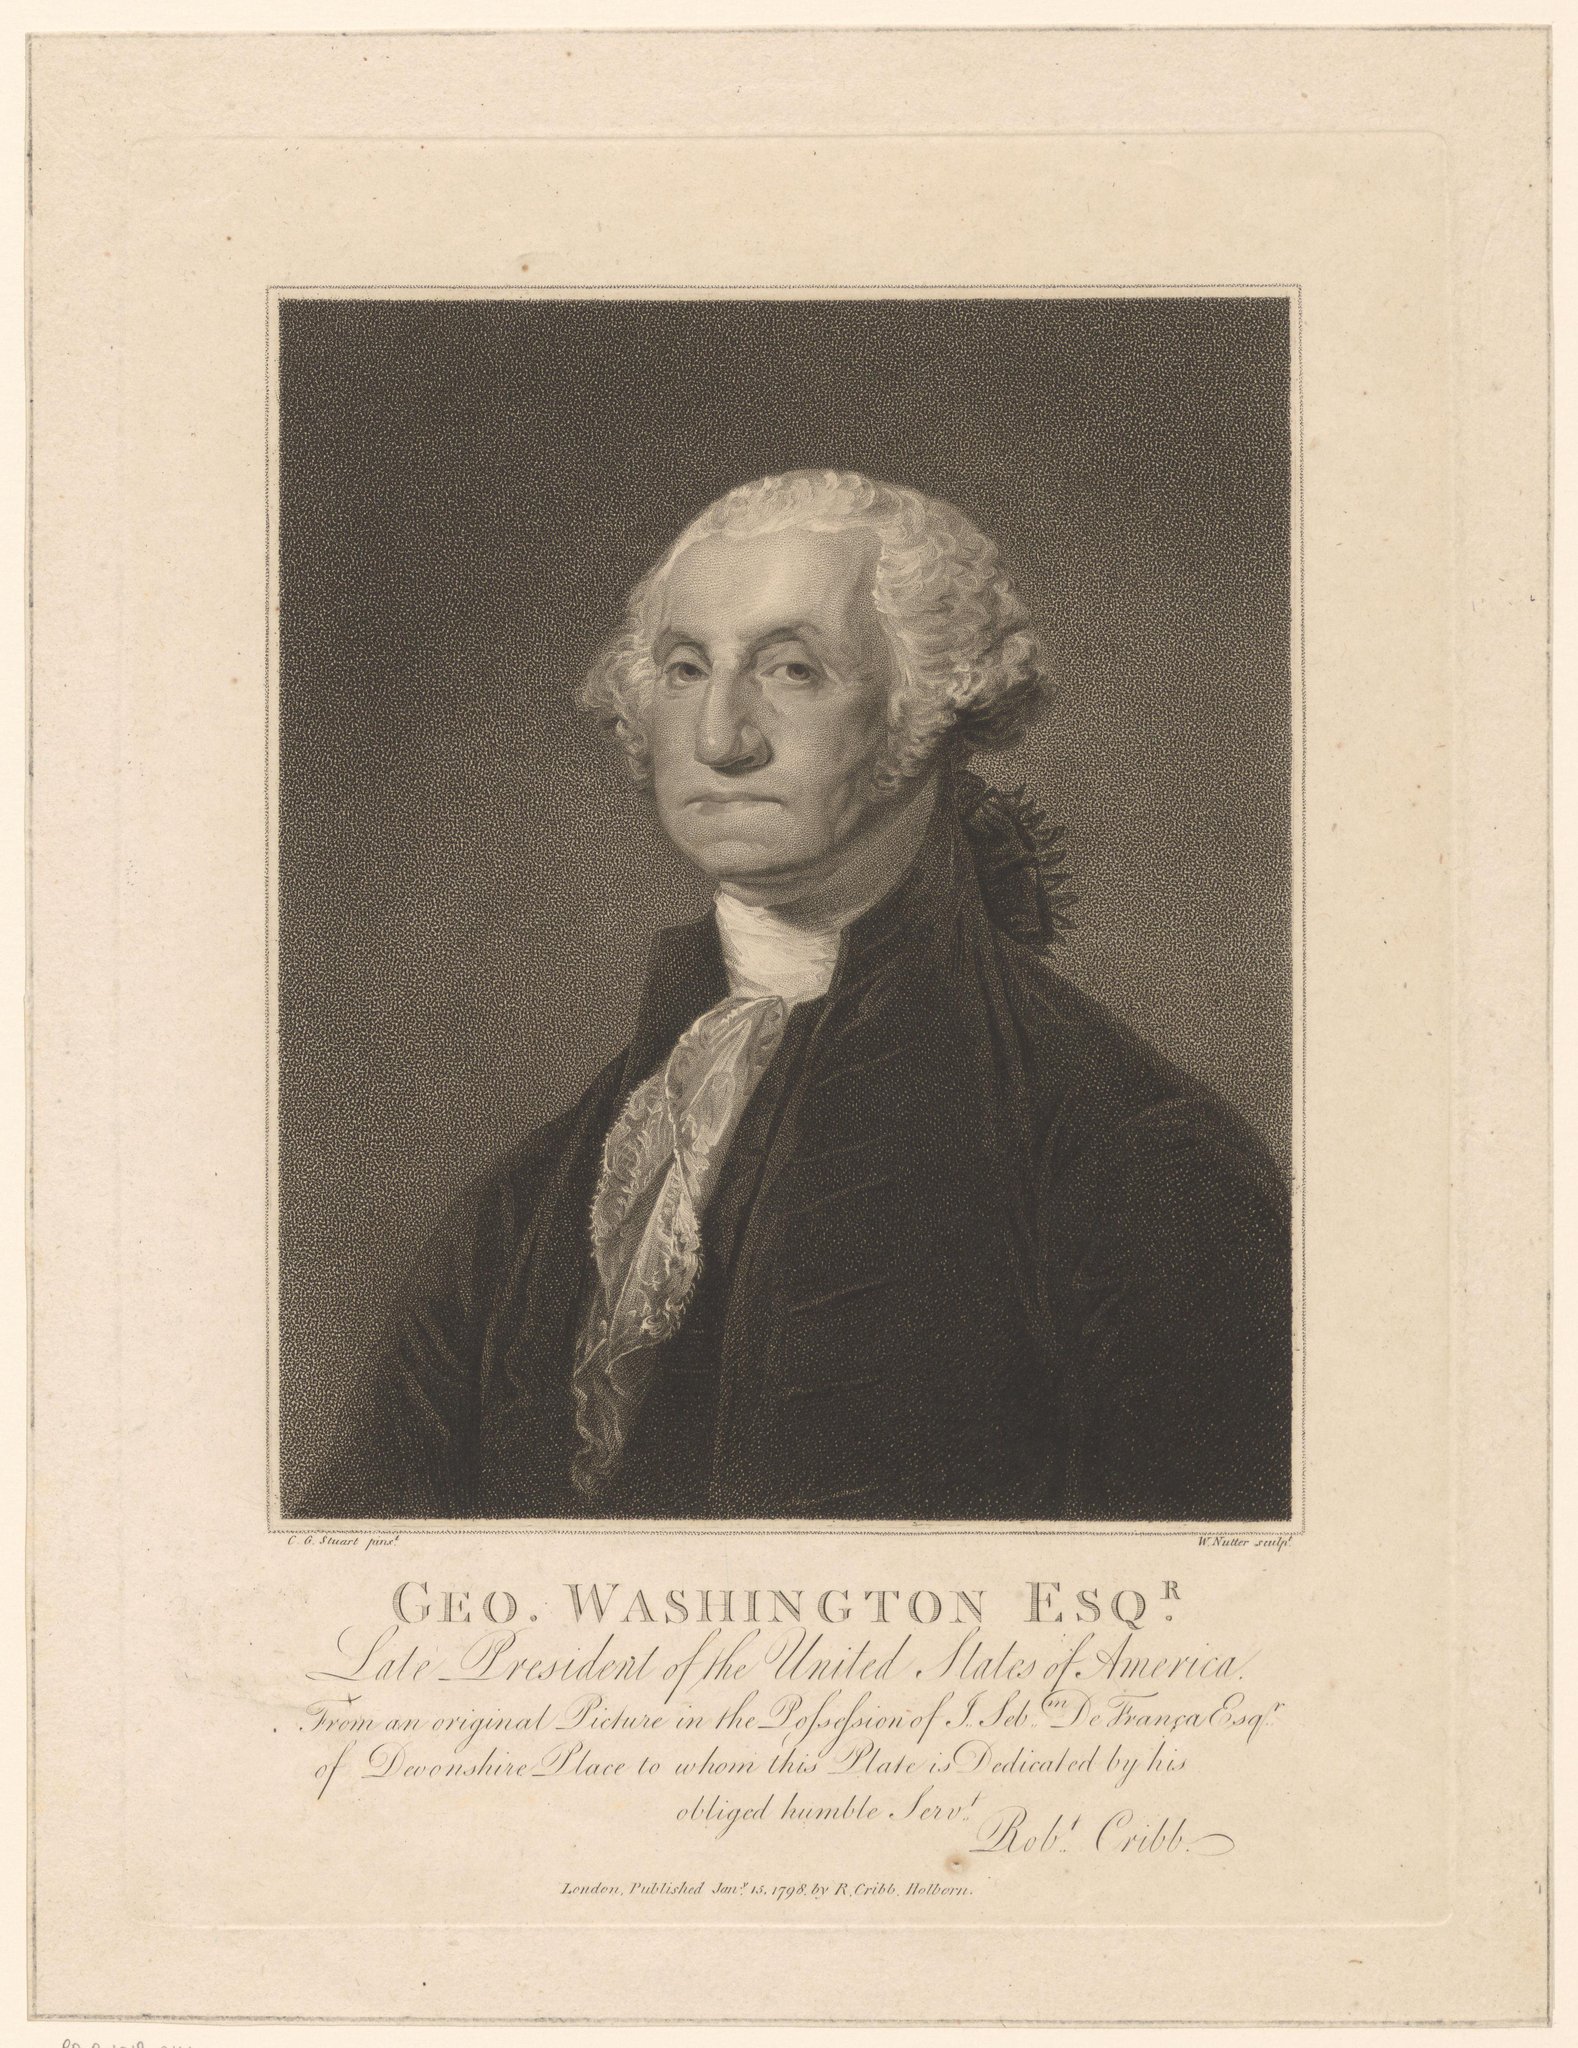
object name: print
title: Portret van George Washington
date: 1701-1798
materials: paper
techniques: engraving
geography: england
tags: president ~ head of republic, historical persons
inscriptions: collector's mark: Lugt 2233